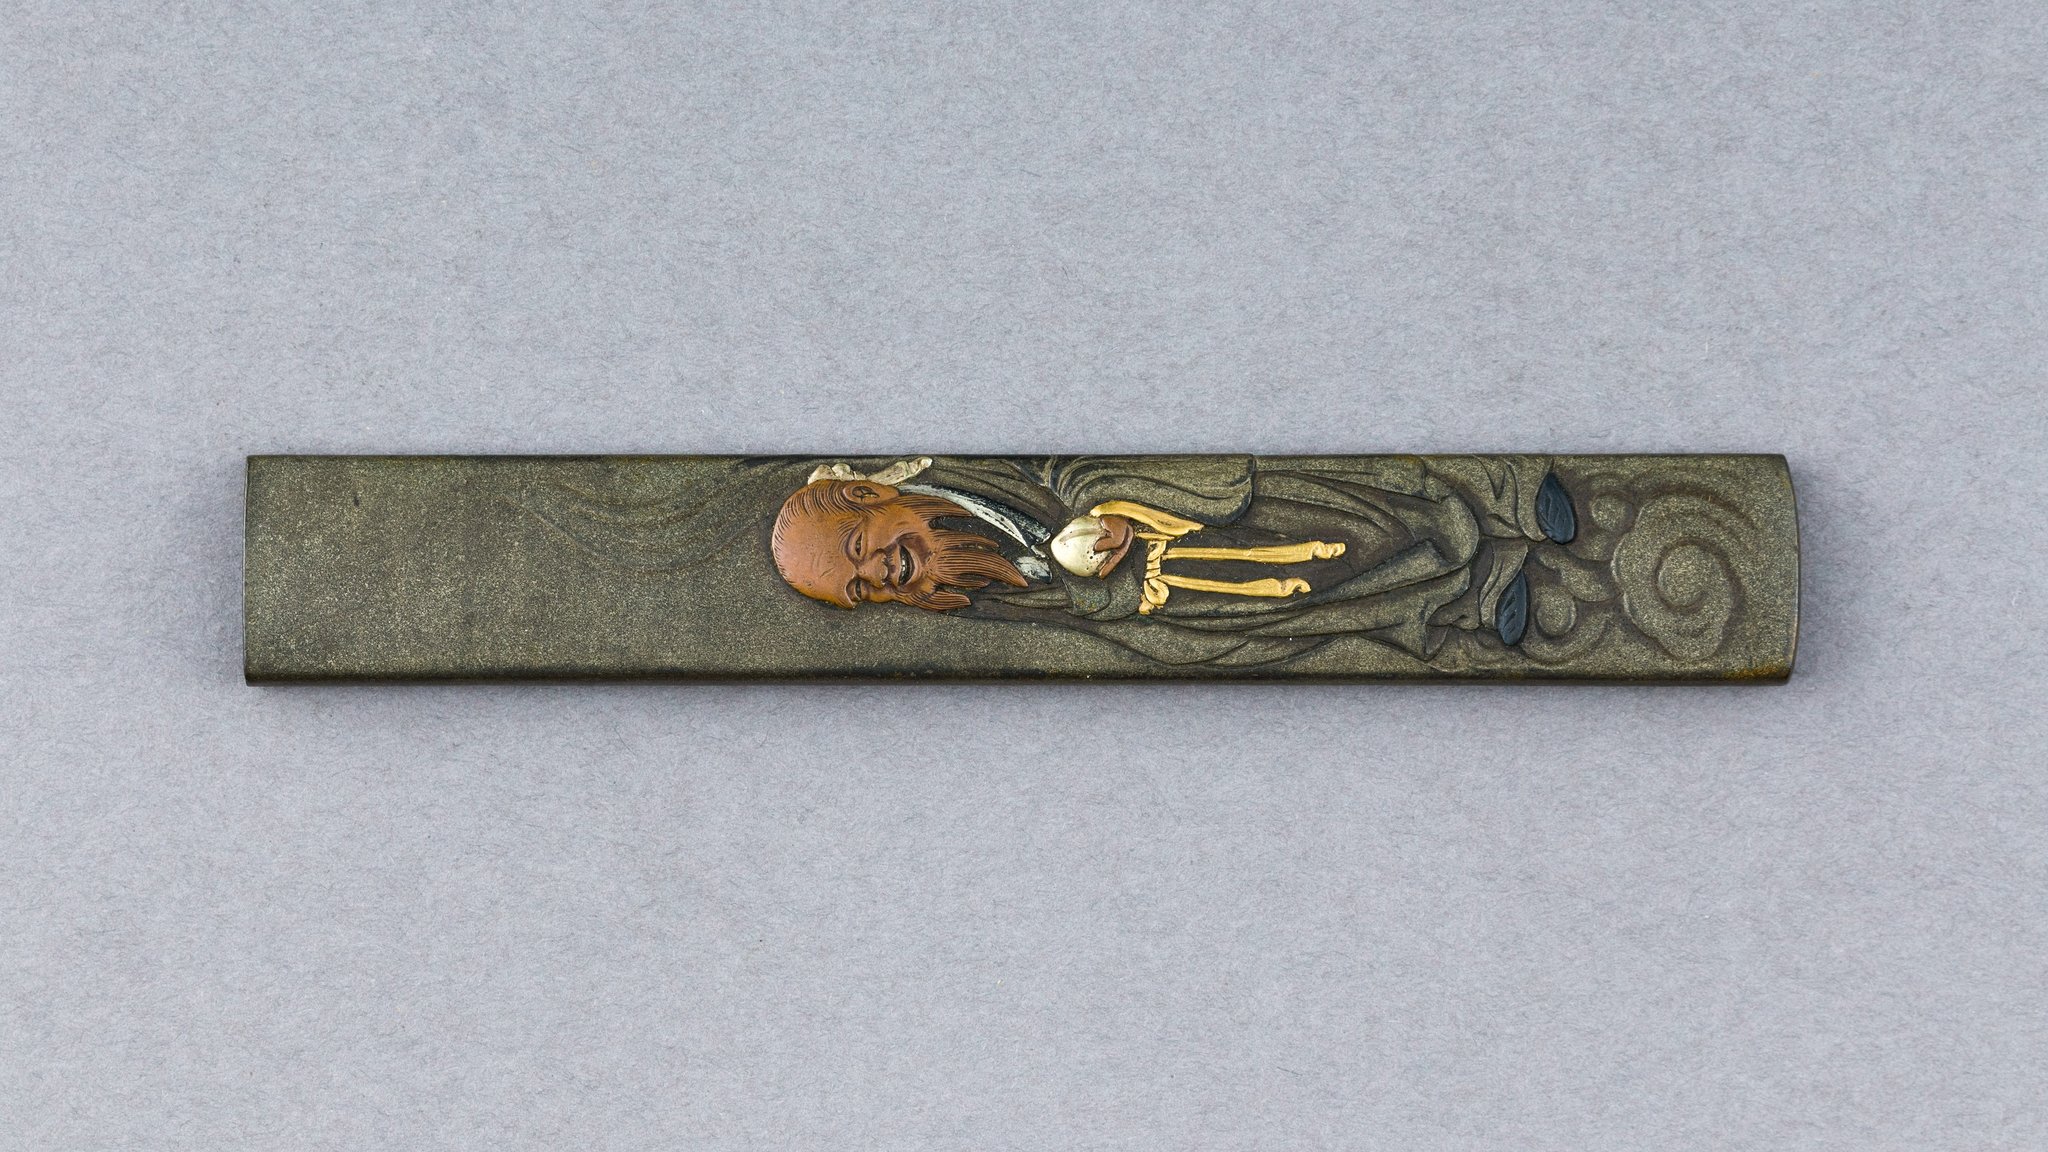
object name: knife handle kozuka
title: Knife Handle (Kozuka)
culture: japanese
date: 1615-1868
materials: copper, gold alloy, silver alloy, gold, silver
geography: japan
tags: men